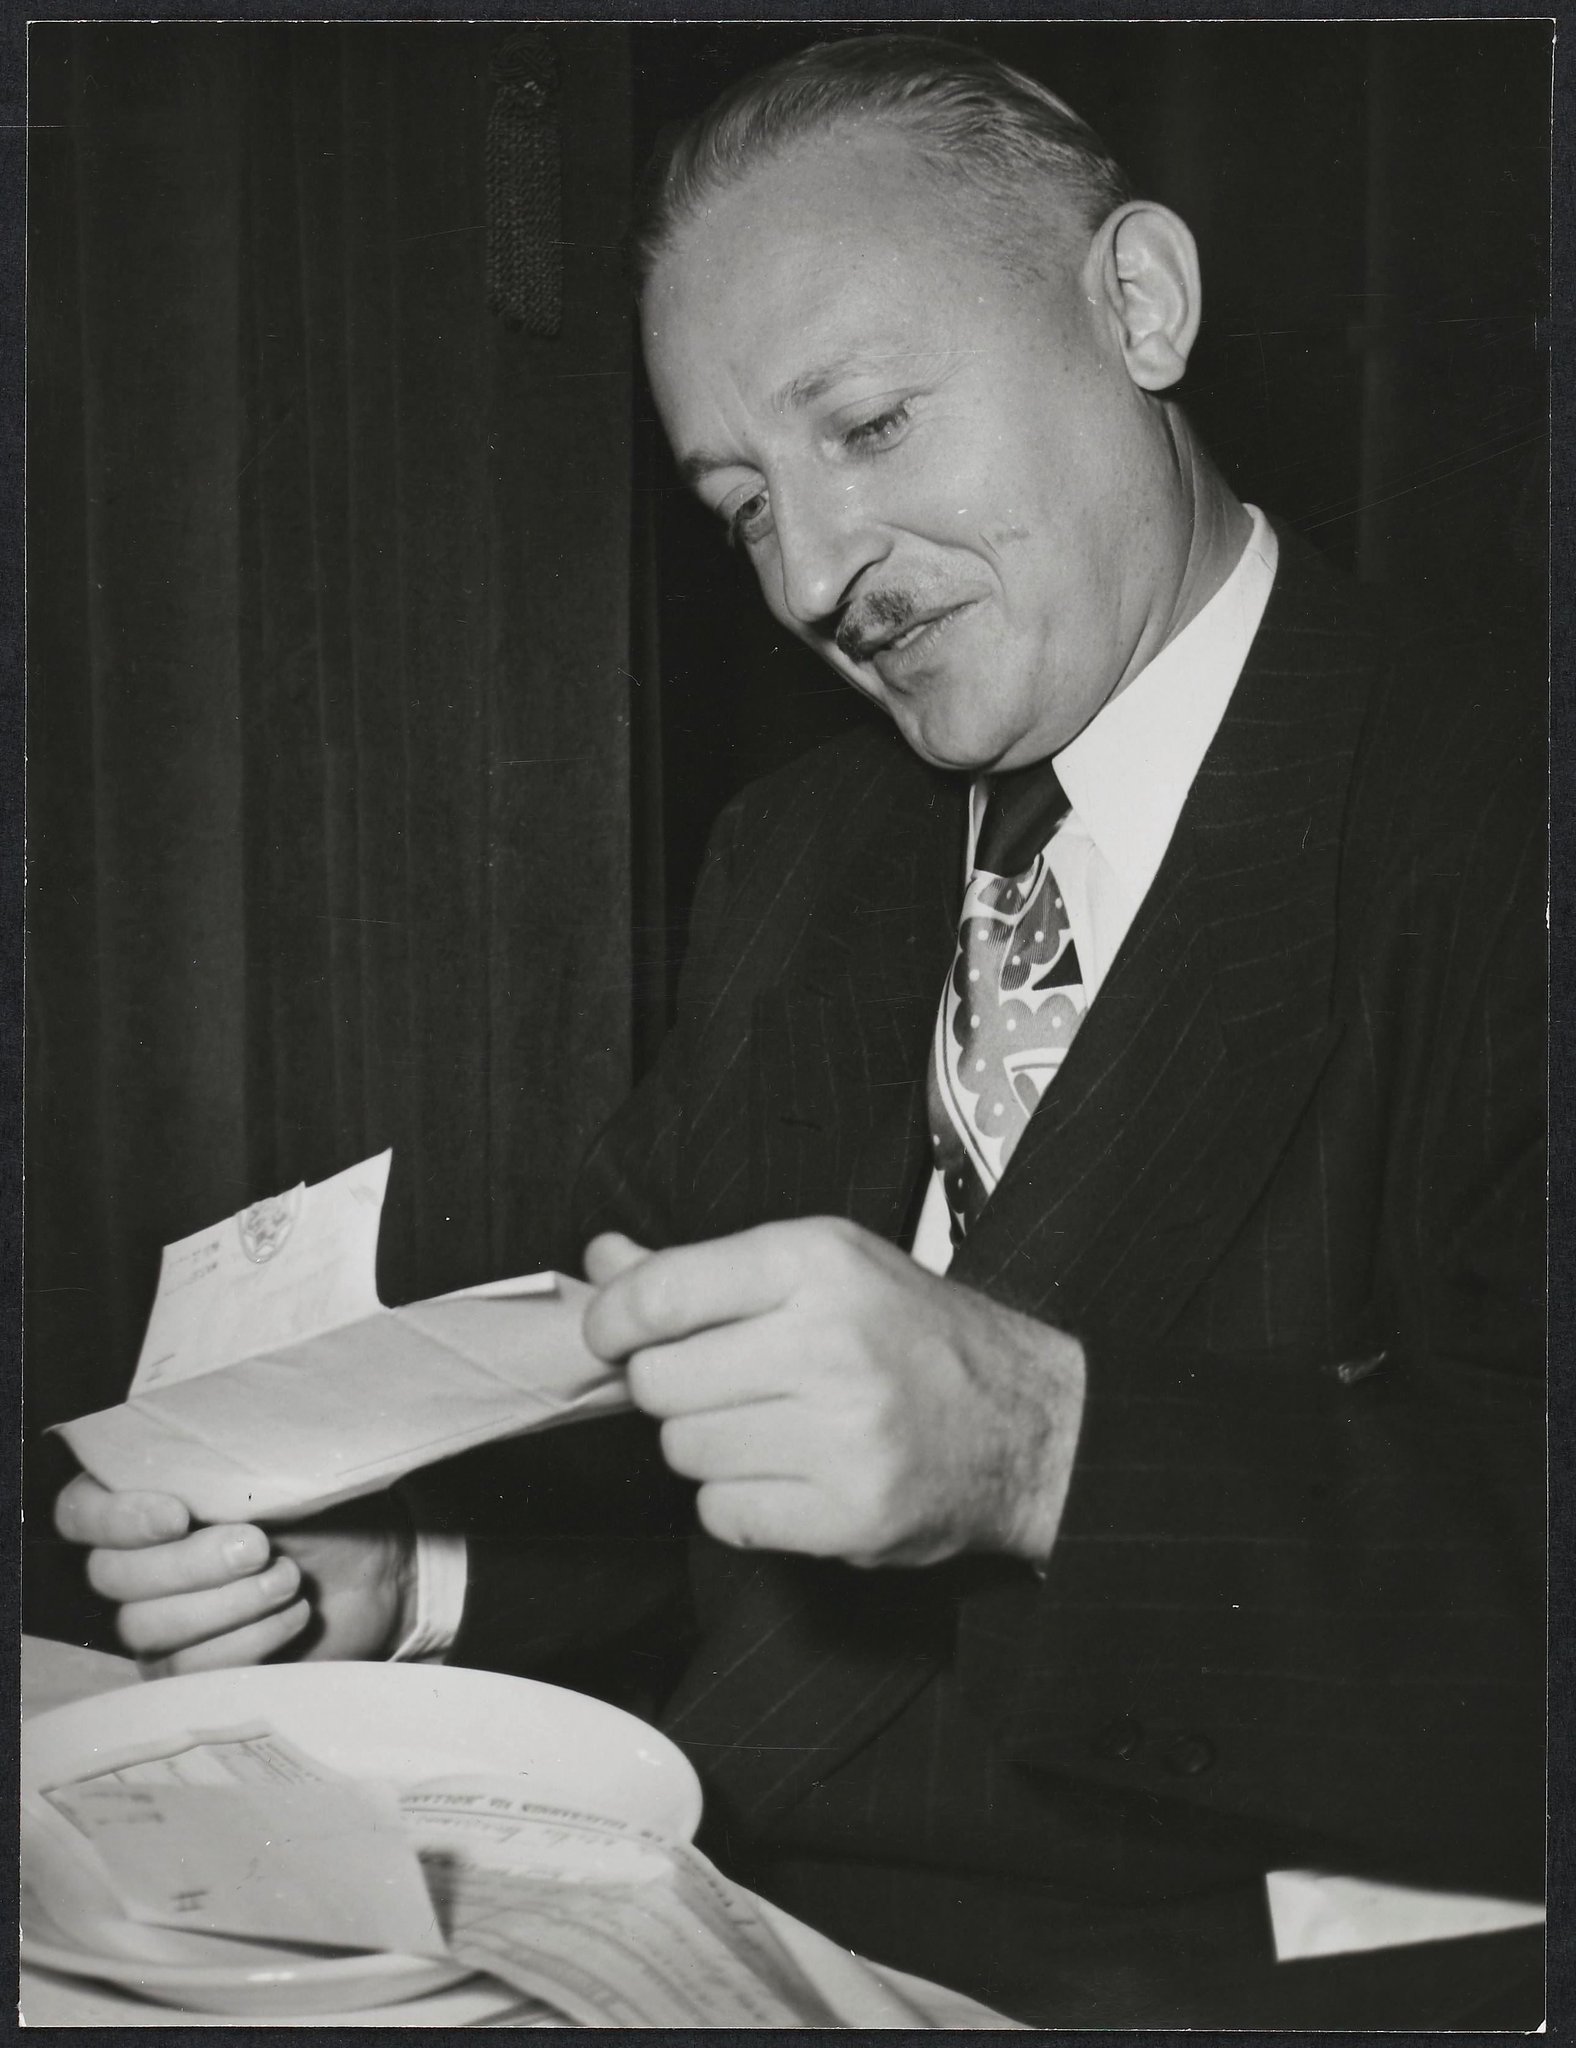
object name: documentary photograph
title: Surinamers in Nederland: 29 foto's uit het archief van Ons Vrije Nederland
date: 1902-1948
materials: photographic support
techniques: photography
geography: the hague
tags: netherlands, suriname, the hague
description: Een van de deelnemers aan de Ronde Tafel Conferentie tussen Nederland en de West: de advocaat Mr. S. W. van der Meer, geboren in Nederland maar al tien jaar woonachtig op Curaçao. Zittend aan een gedekte tafel leest Van der Meer een telegram.